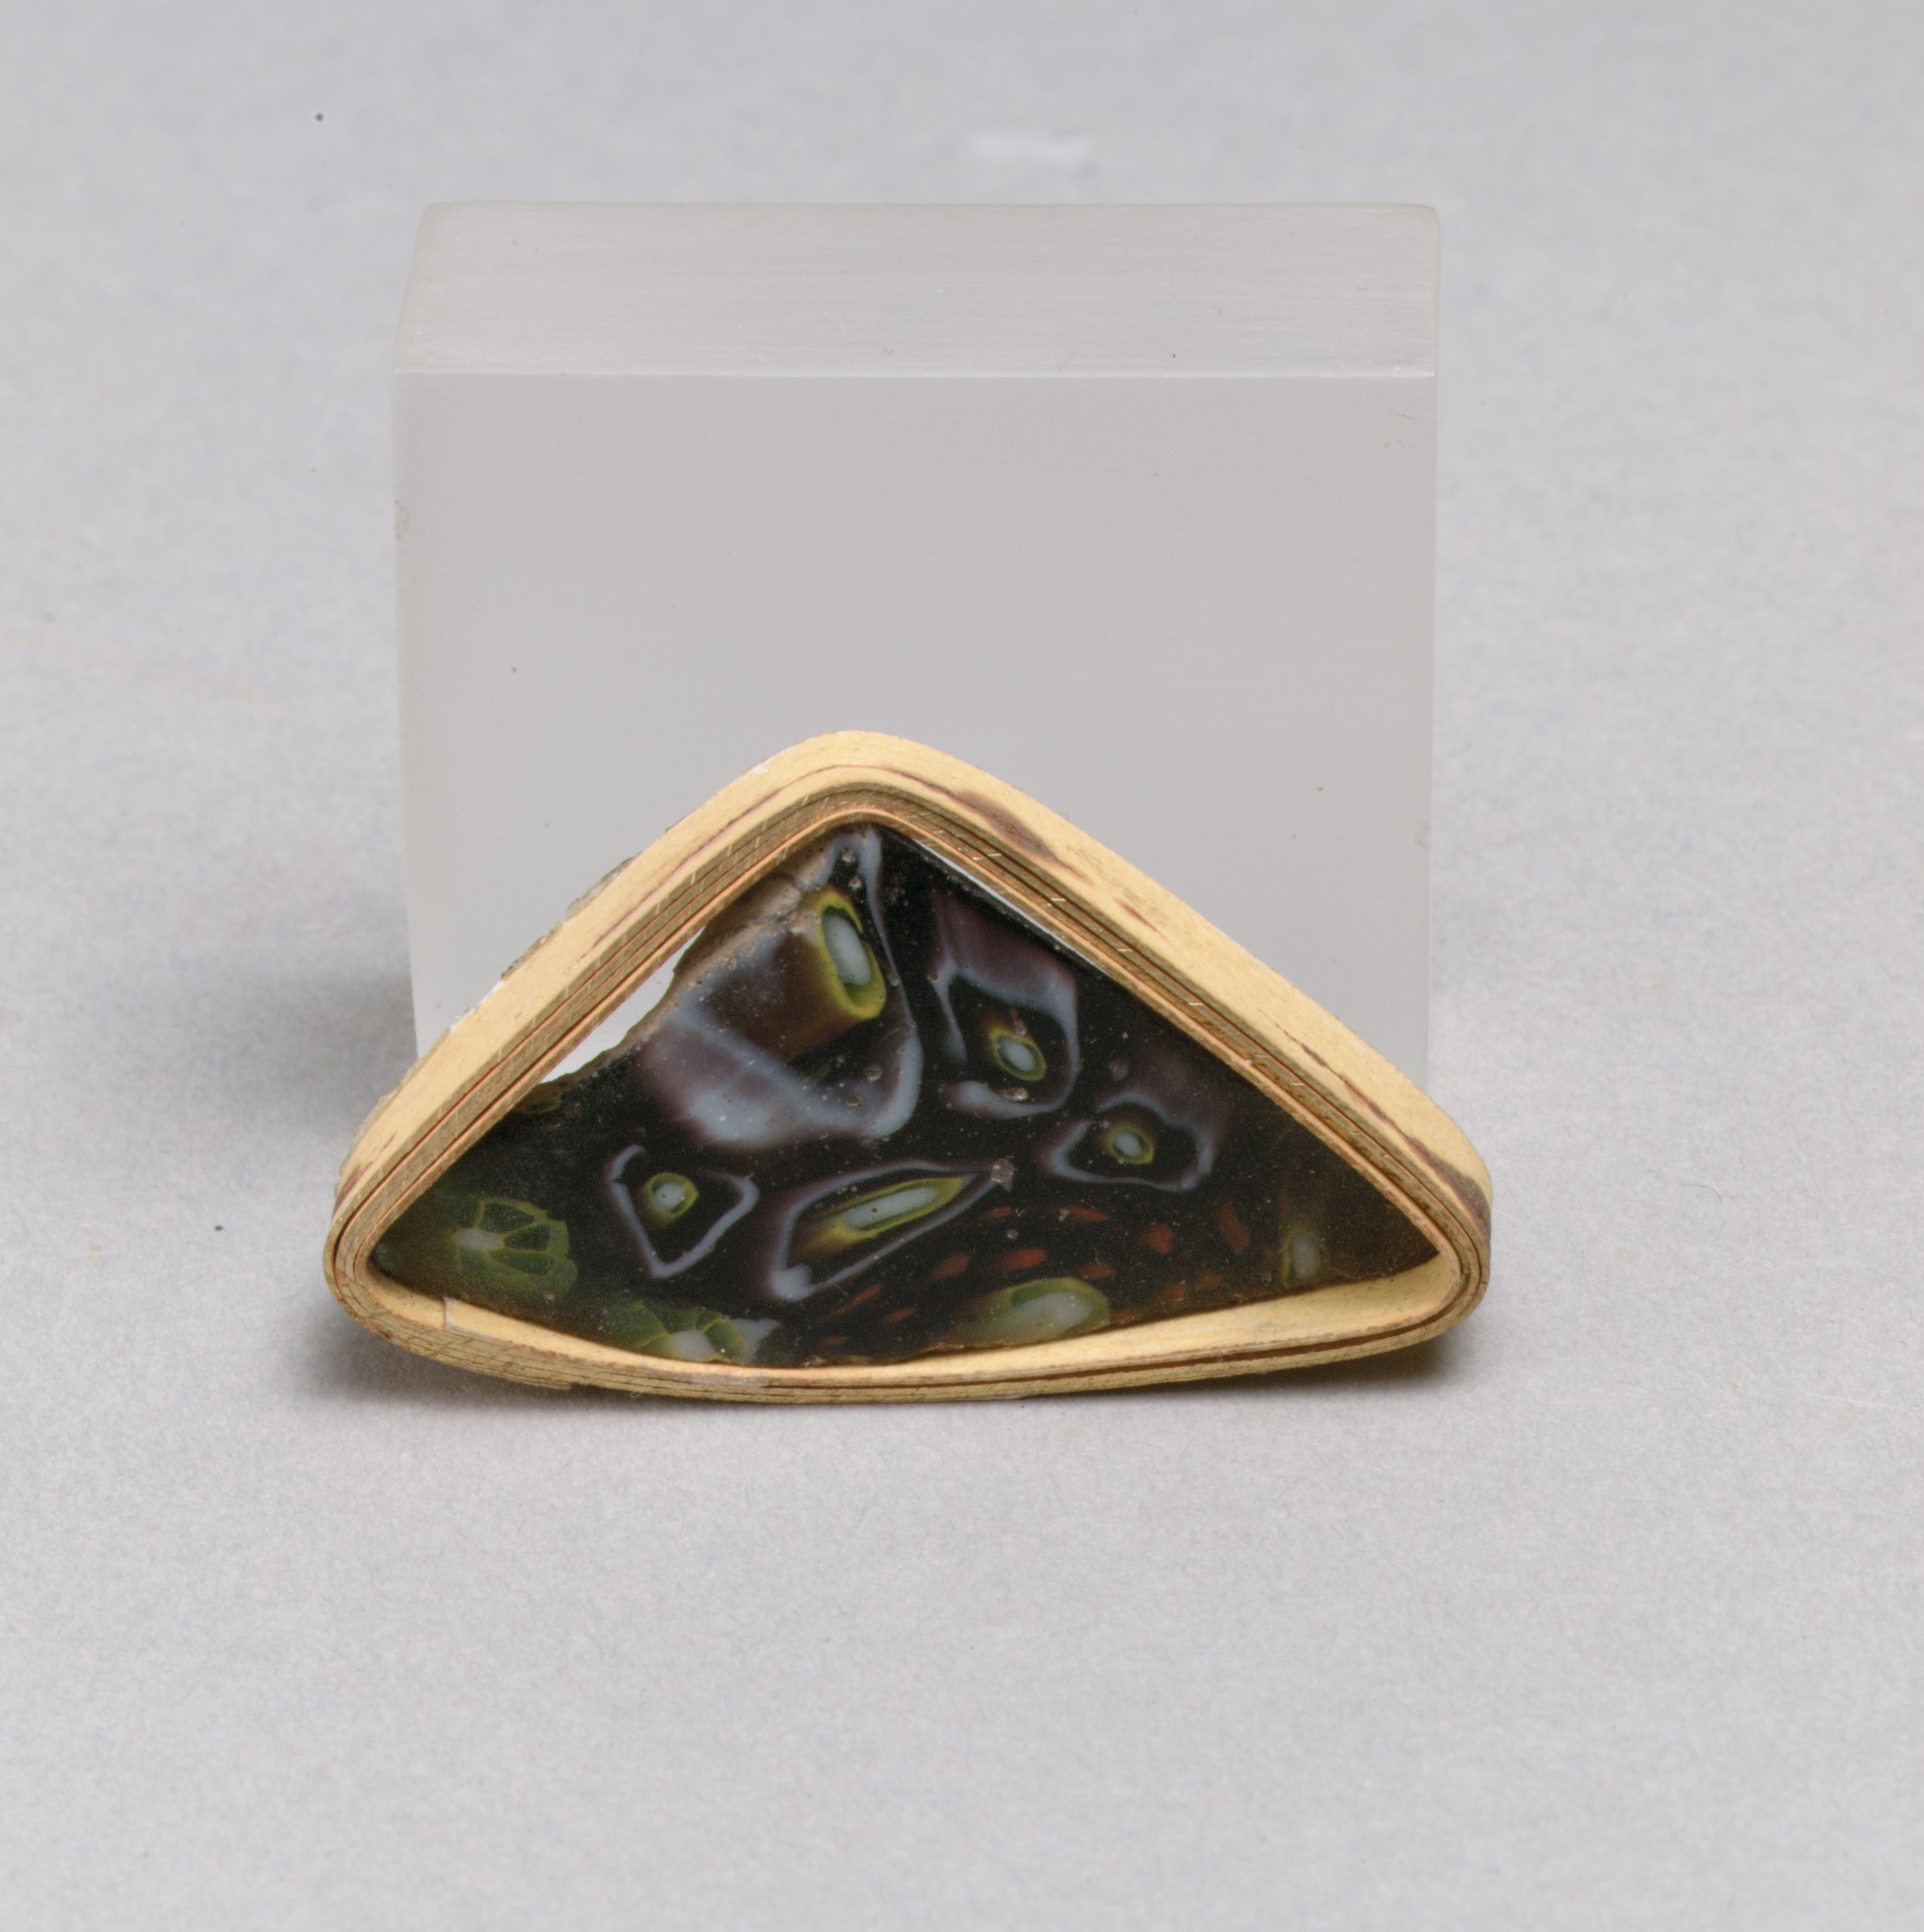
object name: fragment, mosaic bowl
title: Glass mosaic bowl fragment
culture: roman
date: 34 BCE-33 CE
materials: glass